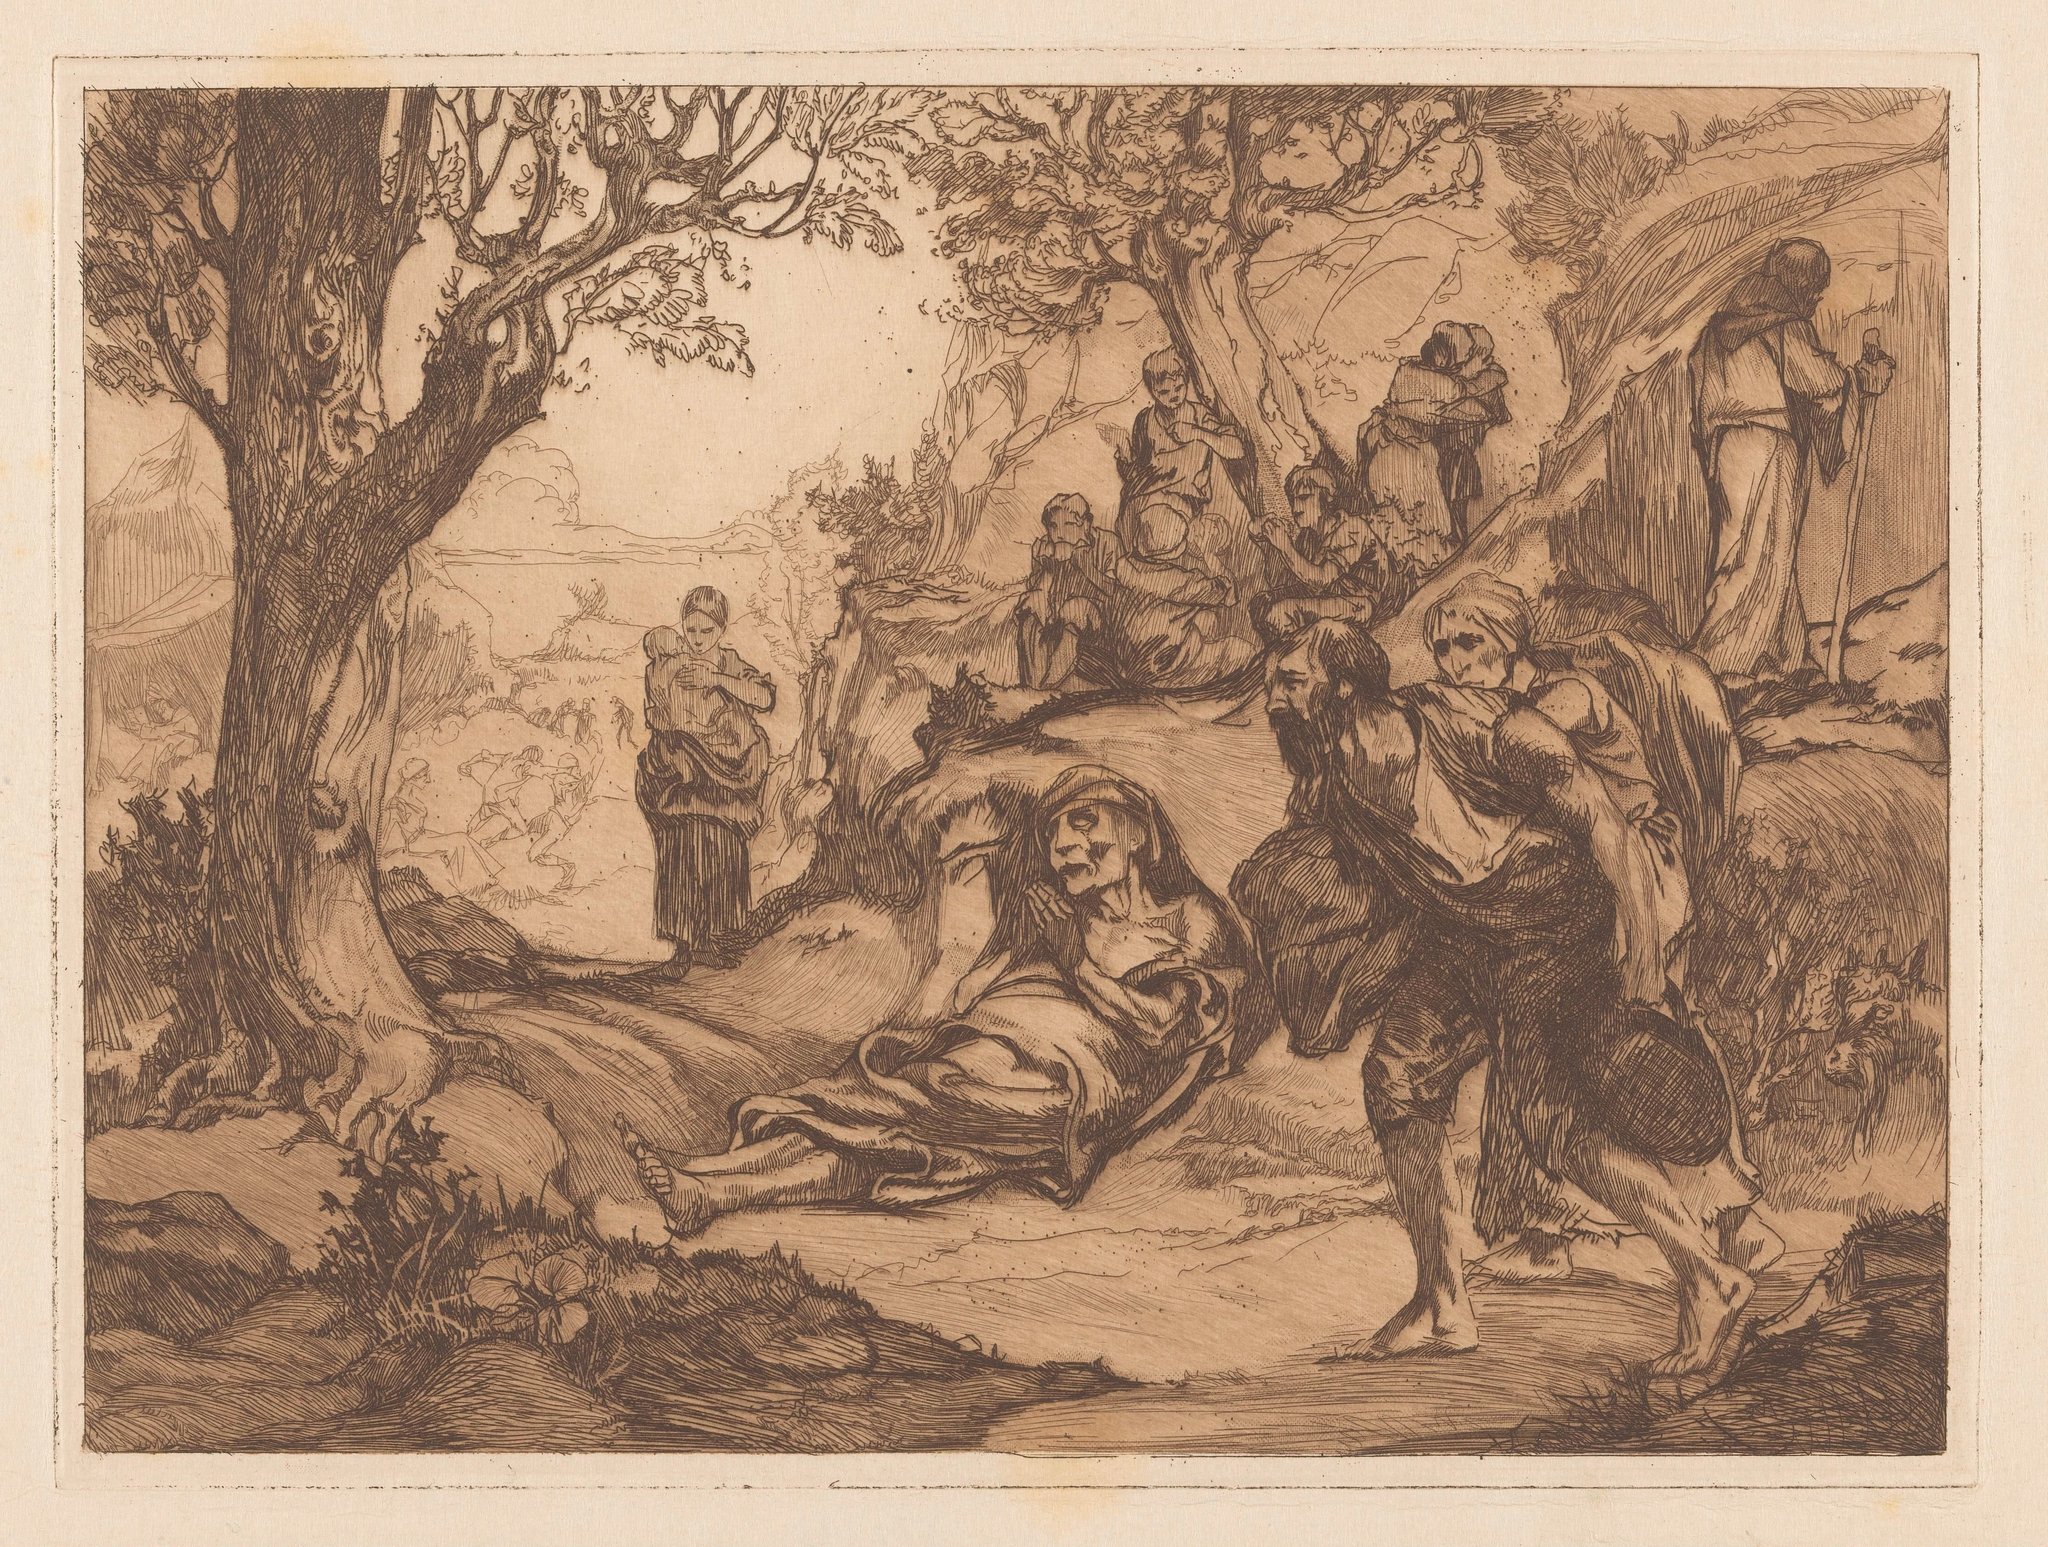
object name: print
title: Landloopers in rotsachtig landschap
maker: johannes josephus aarts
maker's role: draughtsman, print maker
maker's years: 1871-1934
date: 1881-1934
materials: paper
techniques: etching, intaglio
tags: container of textile material: bag, sack, wandering communities, one person praying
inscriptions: collector's mark: Lugt 2228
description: Een groep mannen, vrouwen en kinderen, houdt zich op rond twee bomen. Rechts op de voorgrond lopen een man en een vrouw met zakken bagage. Links van hen een liggende, biddende vrouw. Bij de rots rechts op de achtergrond nog enkele figuren.